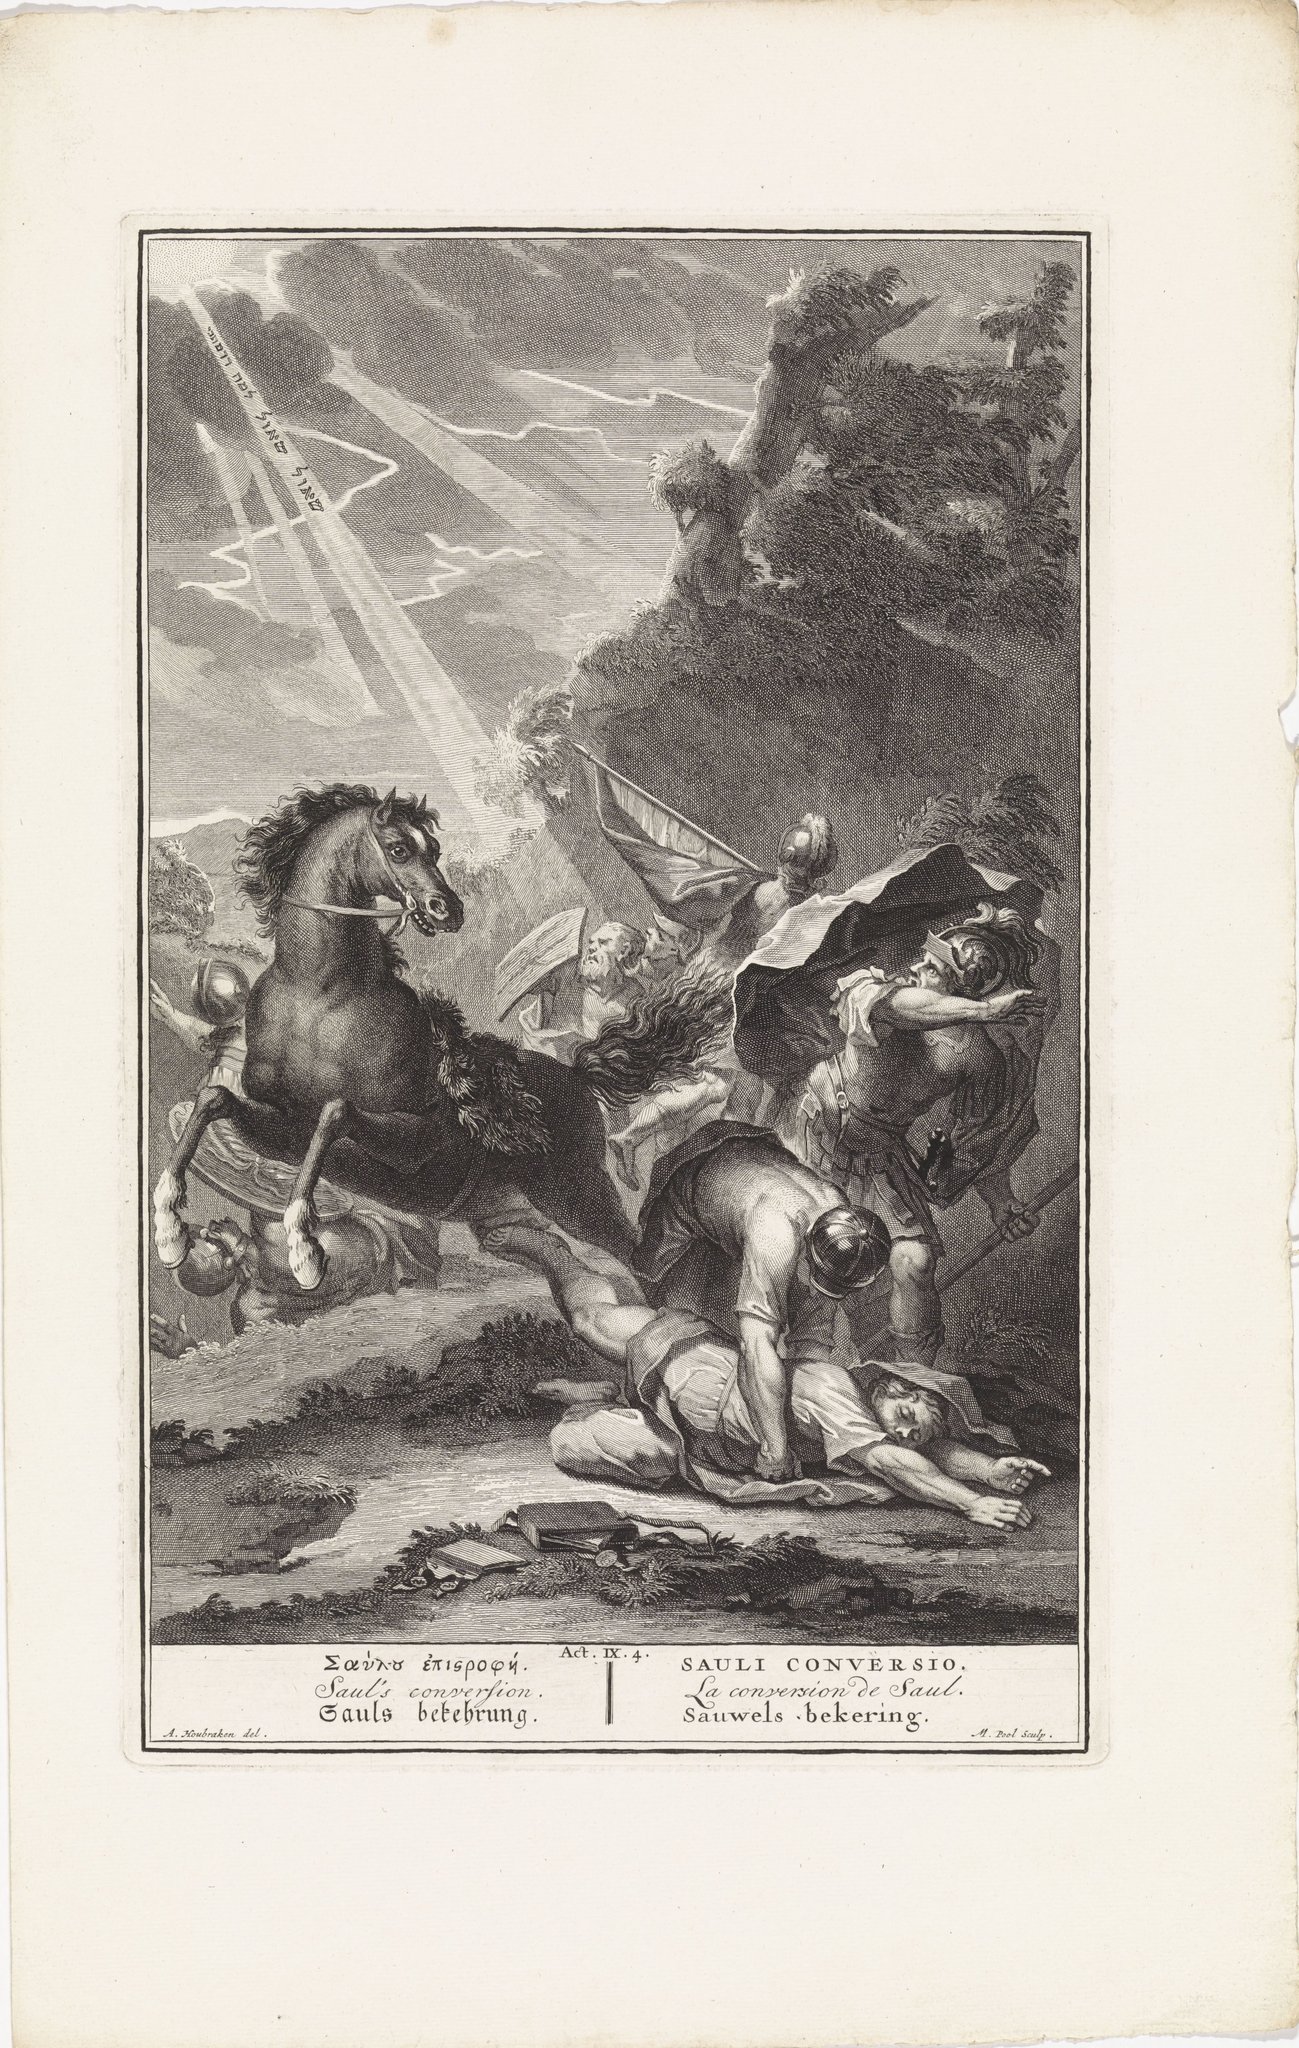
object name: print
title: Bekering van Paulus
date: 1705-1720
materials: paper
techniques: engraving, etching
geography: amsterdam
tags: on the way to damascus christ appears to saul, who falls from his horse and is blinded by the light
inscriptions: inscription: ‘Utrechts Fundatie huijs’, collector's mark: Lugt 2228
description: Op weg naar Damascus openbaart Christus zich aan Saulus. Hij verschijnt uit de wolken als lichtstralen en spreekt hem aan. Saulus is zojuist van zijn paard geworpen en ligt op de grond. Soldaten schieten hem te hulp. Na zijn bekering heet hij Paulus. Illustratie van de bijbeltekst Hand. 9:4. Onder de voorstelling de titel in het Hebreeuws, Engels, Duits, Latijn, Frans en Nederlands.